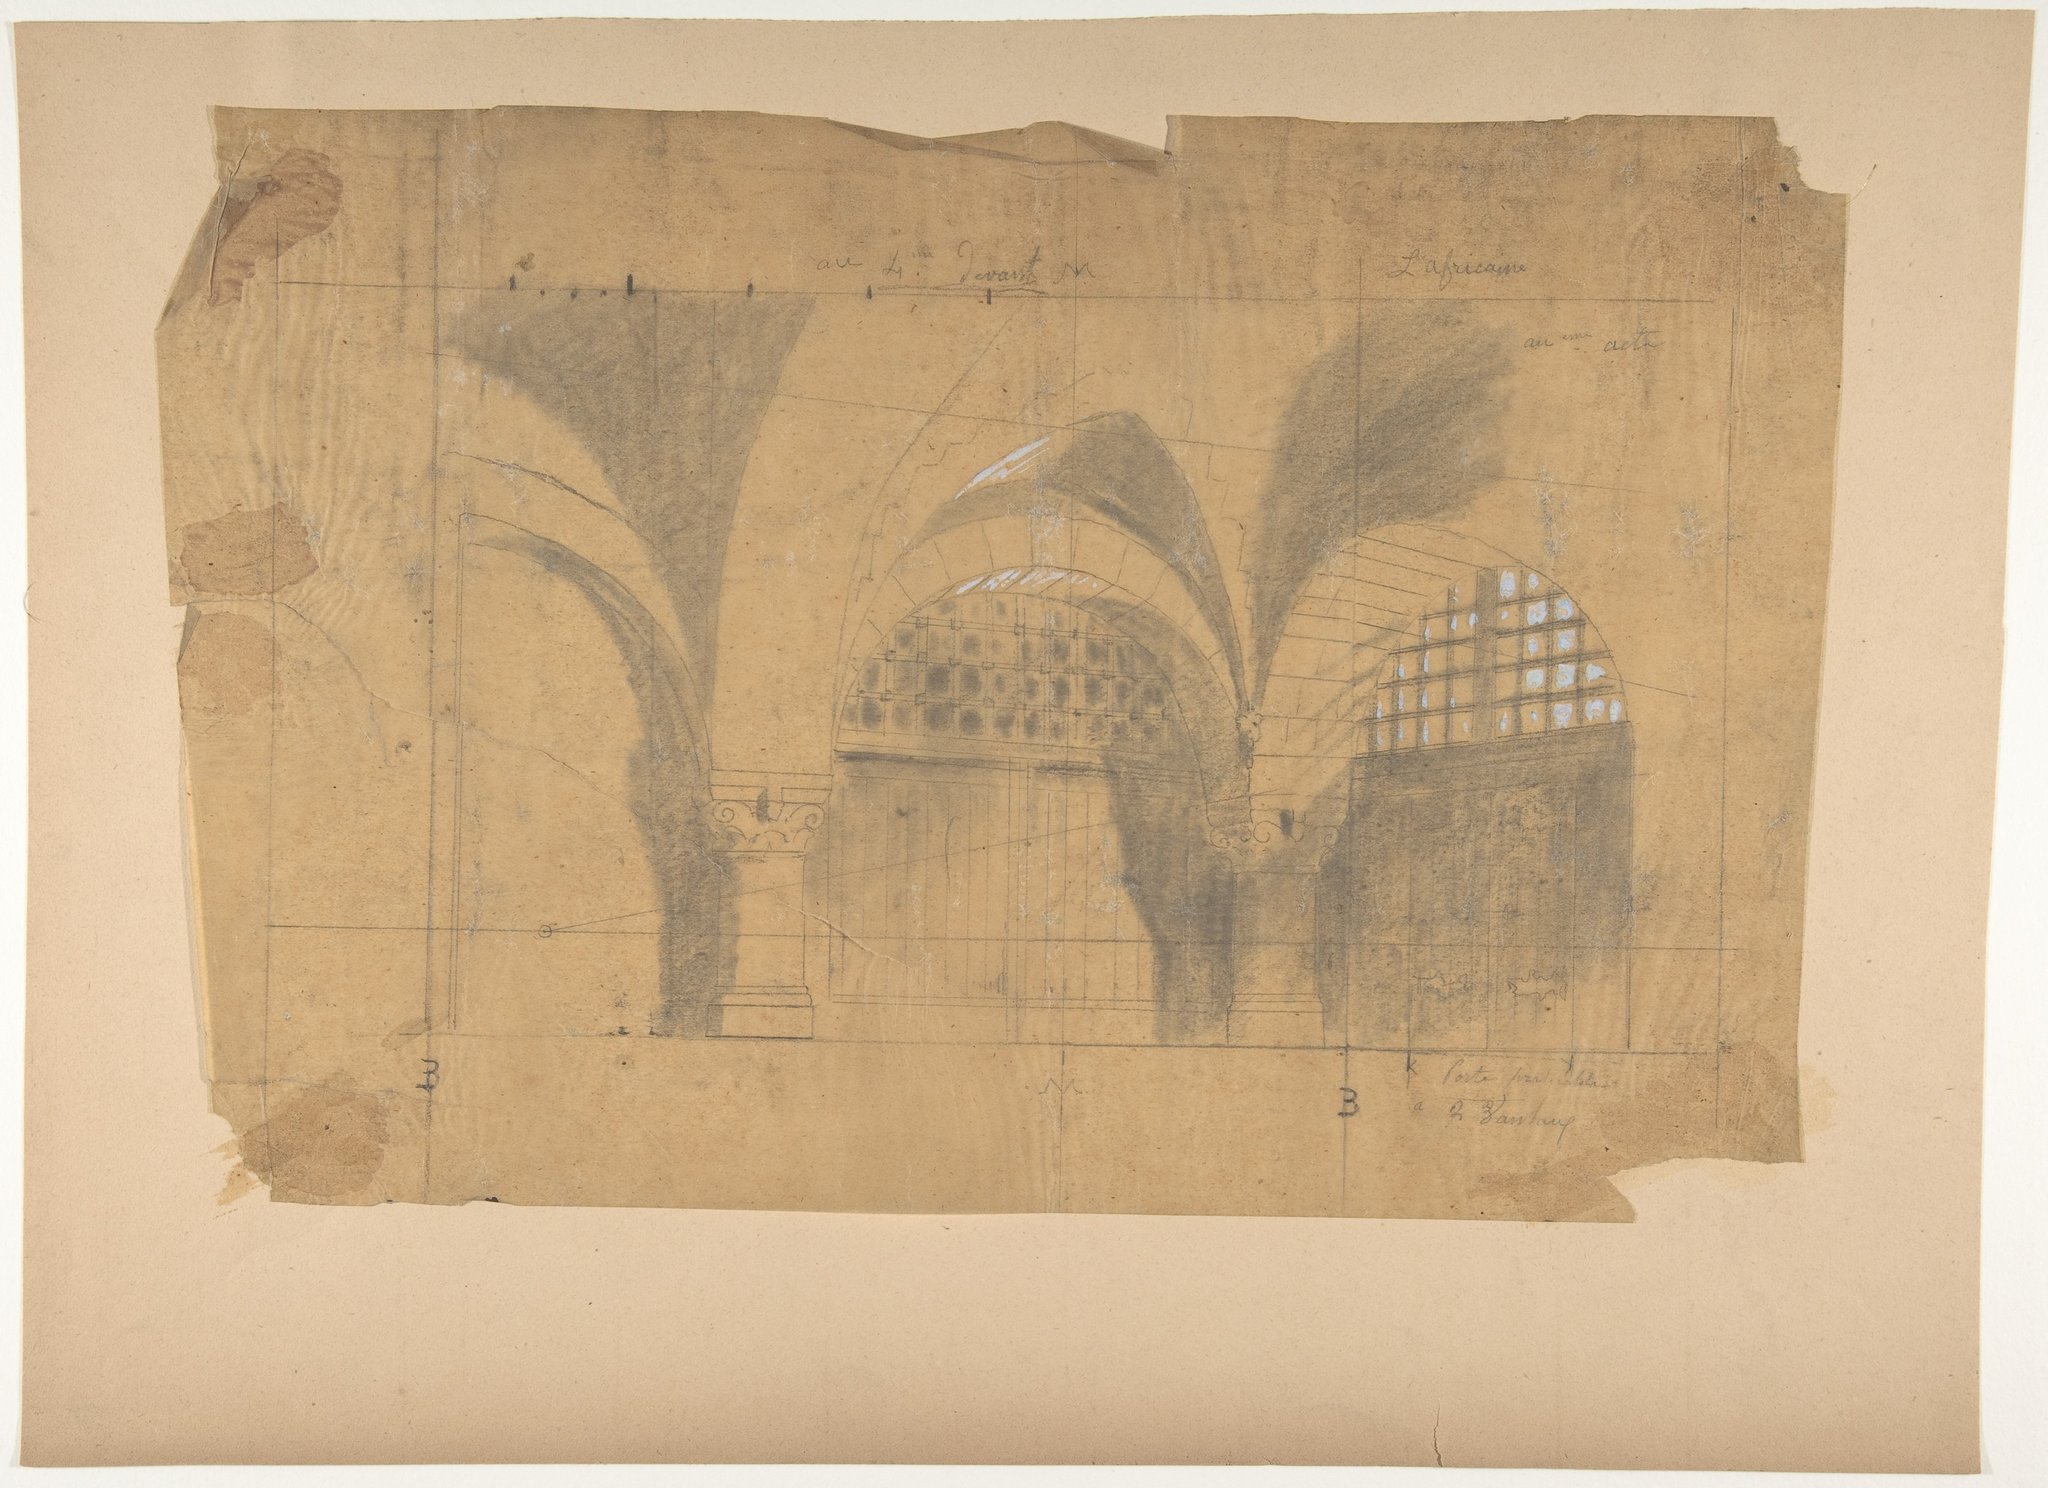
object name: drawing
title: Design for a Stage Set at the Opéra, Paris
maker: eugène cicéri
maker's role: artist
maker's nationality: french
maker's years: 1813-1890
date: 1830-1890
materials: graphite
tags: stage design